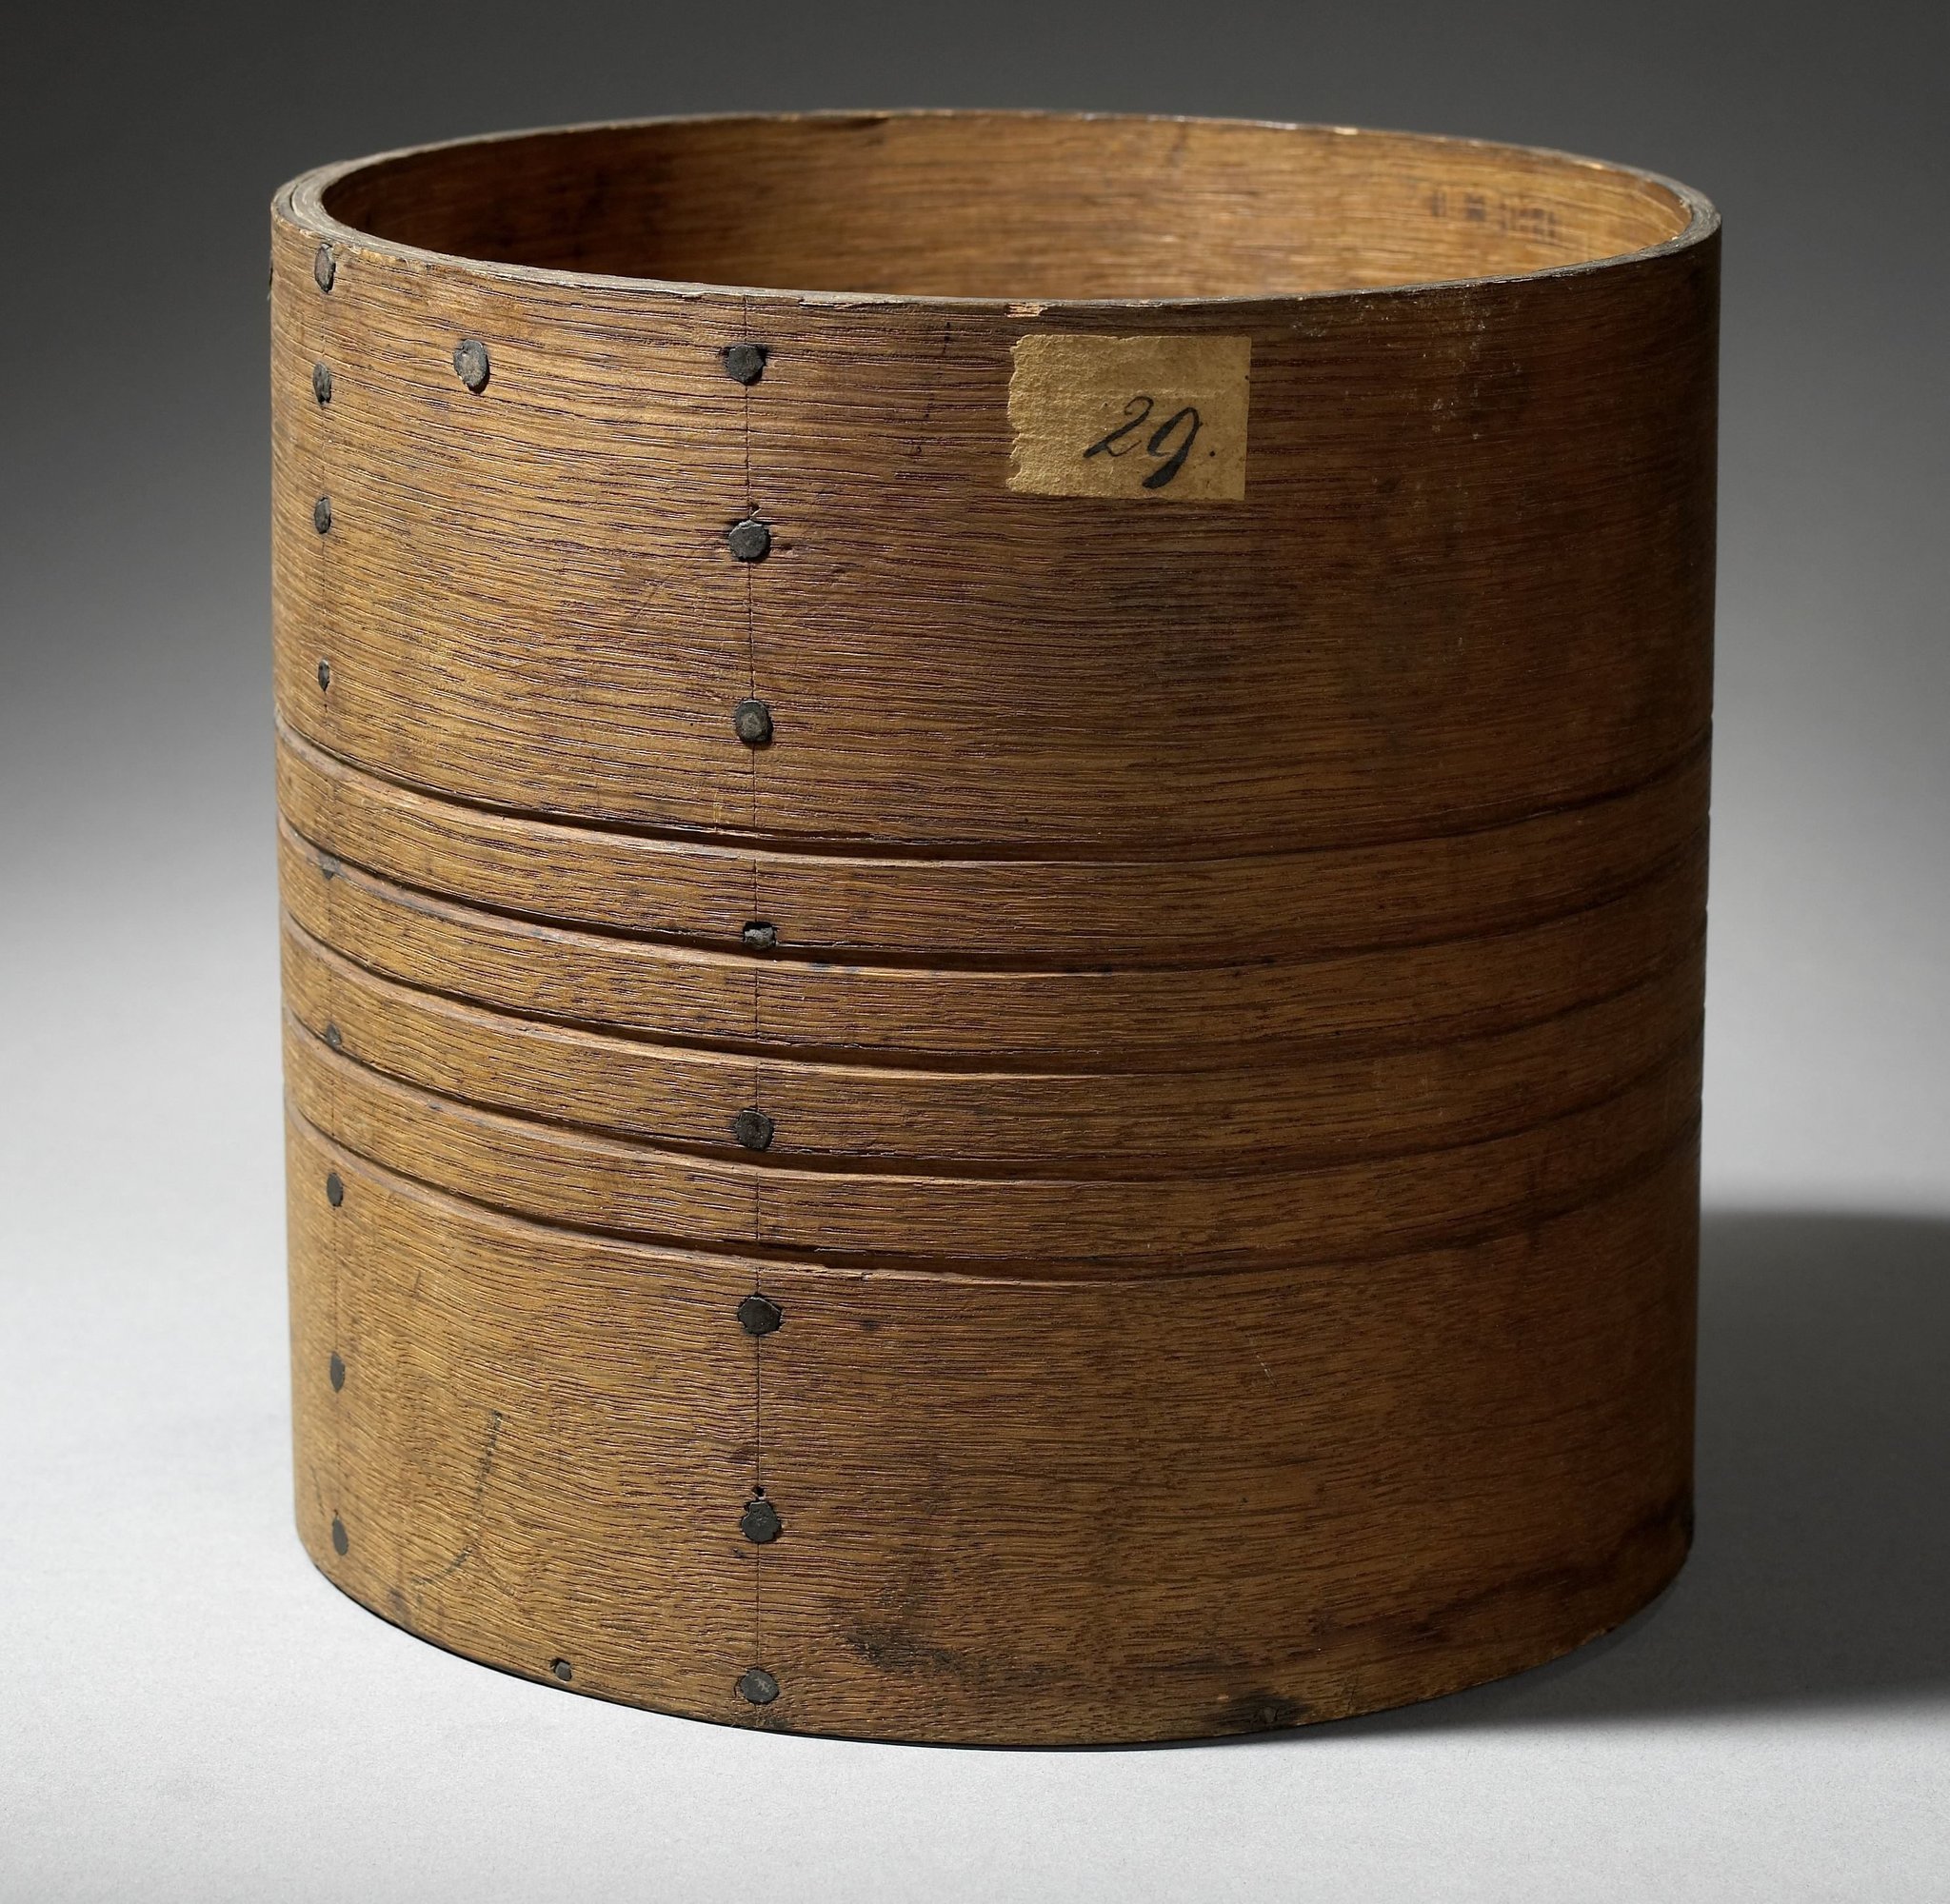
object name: graanmaat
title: Graanmaat van ½ decaliter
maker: Anonymous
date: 1803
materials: wood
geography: netherlands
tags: netherlands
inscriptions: title: ‘Demi decalitre à grains / 29’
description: Houten graanmaat van ½ decaliter met etiket.